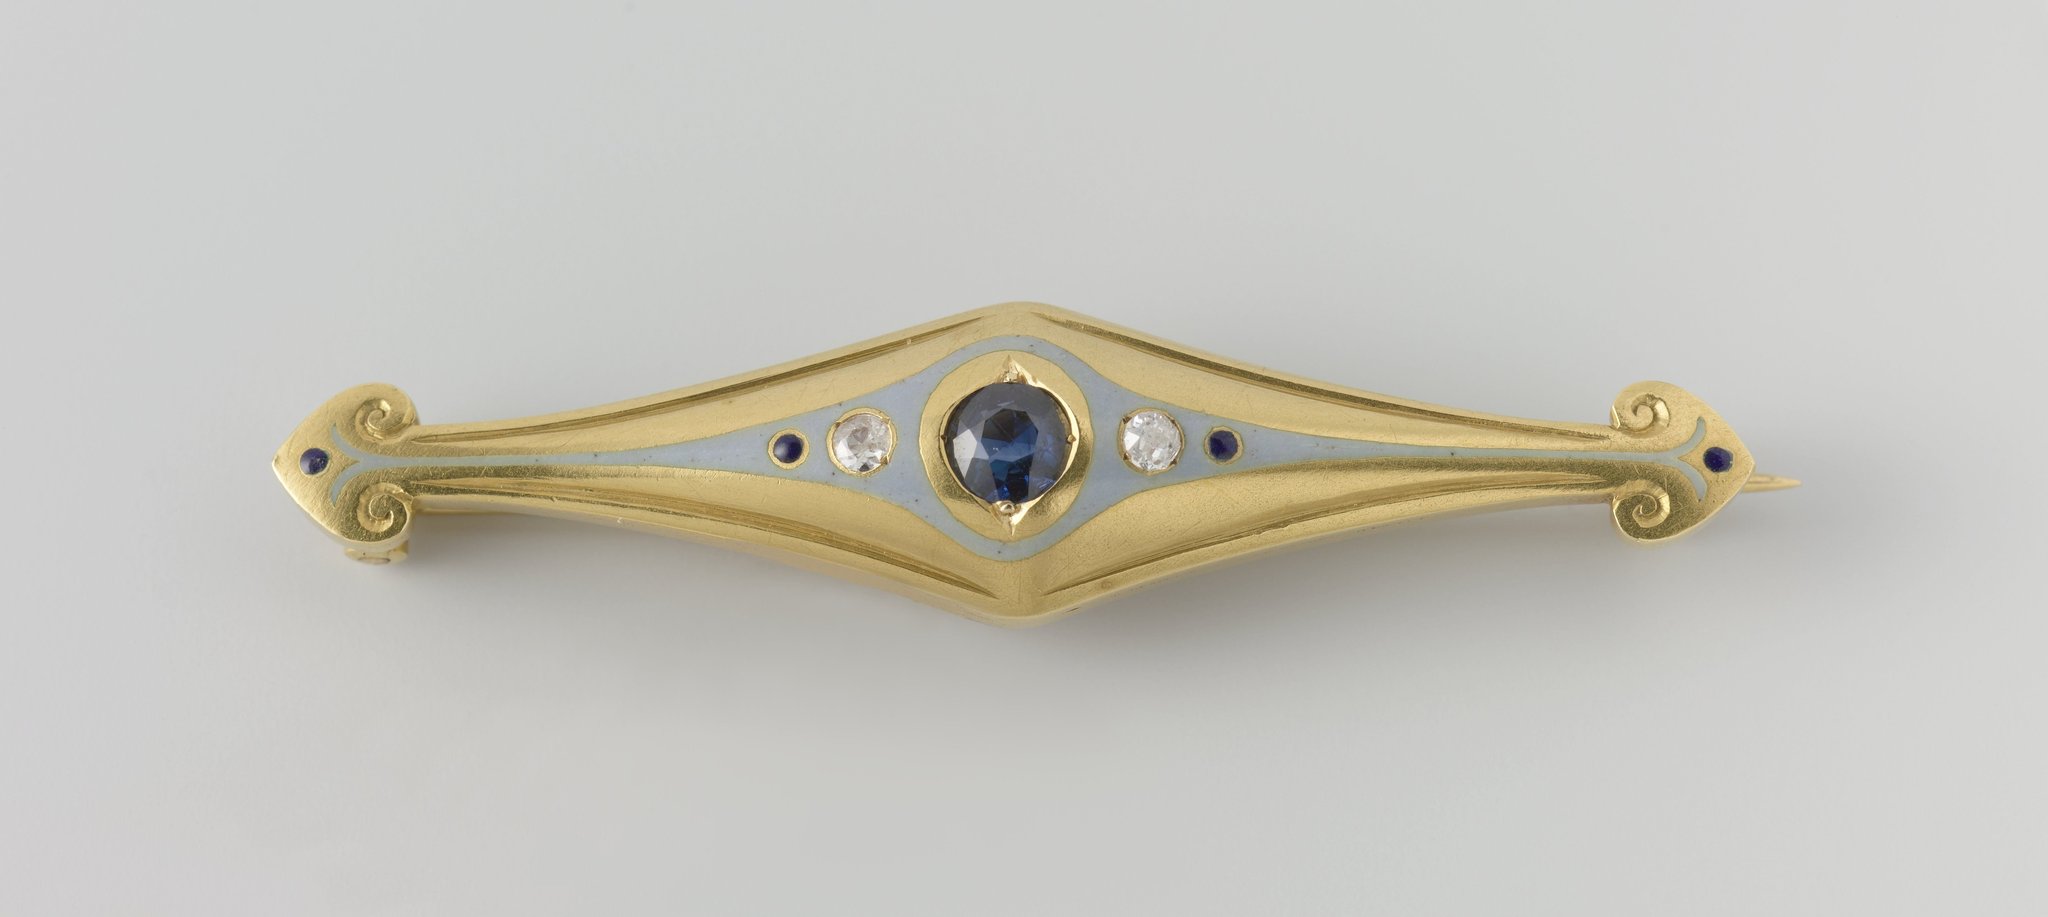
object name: jewellery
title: Broche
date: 1908-1911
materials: diamond, gold, gemstone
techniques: enameling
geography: amsterdam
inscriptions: alloy mark: ‘750 in bloem (Nederland, vanaf 1955)’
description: Jewellery. Gold, silver, enamel and semi-precious stones. Amsterdam, c. 1908 - 1911, by L.W. van Kooten, designed by Bert Nienhuis. Given by the Prins Bernhard Fonds, 1980.